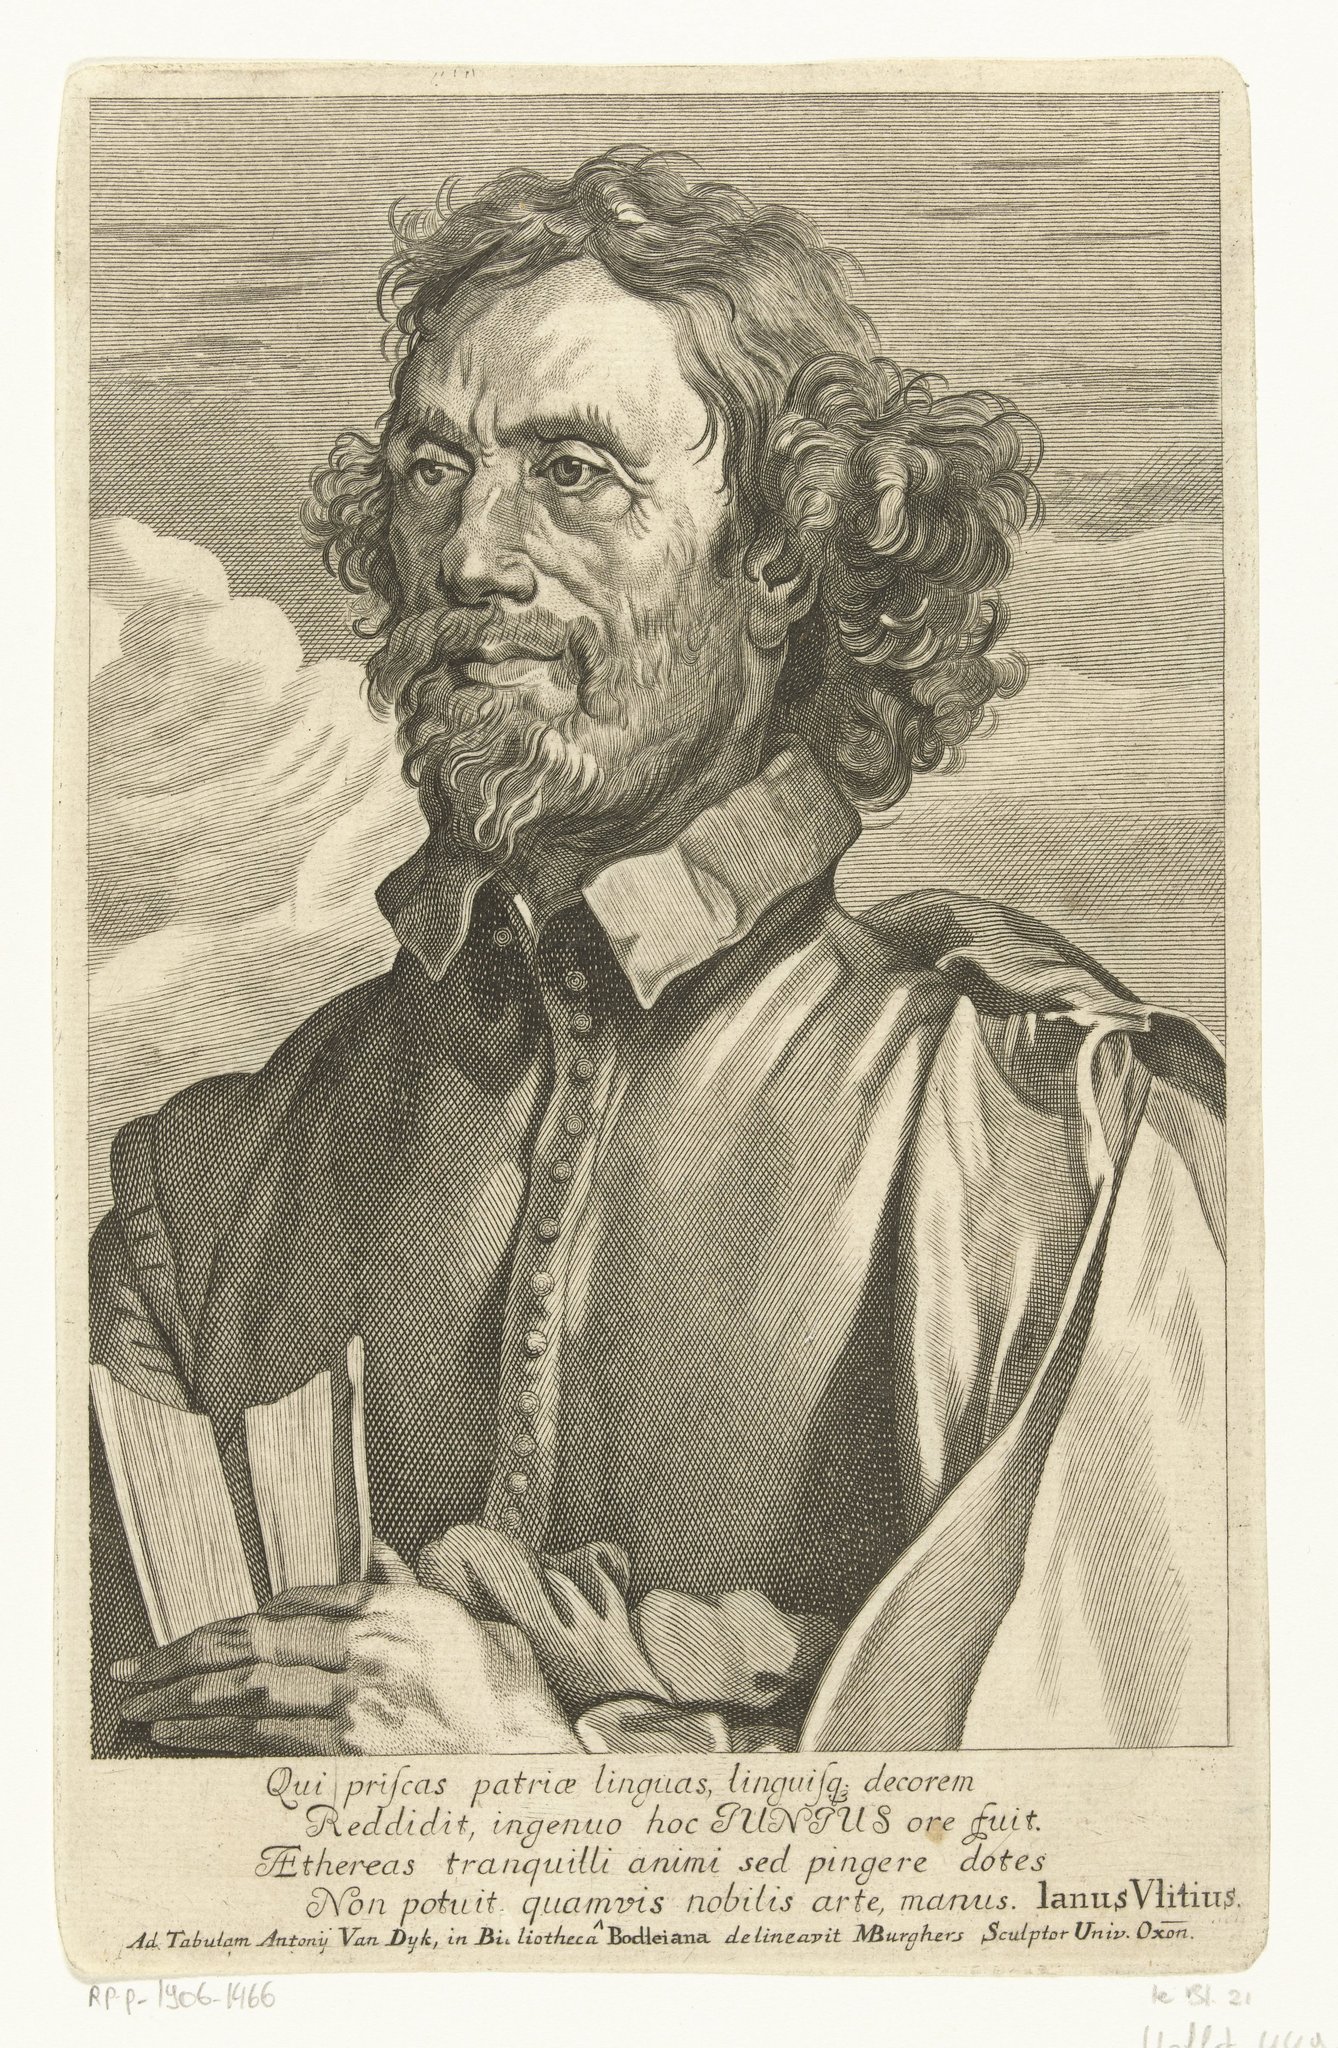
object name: print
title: Portret van François Junius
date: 1698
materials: paper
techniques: engraving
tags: heidelberg, windsor, filoloog, oudheidkundige, franciscus junius (ii)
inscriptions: collector's mark: Lugt 2228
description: Titelpagina uit Koning Alfred, 'An. Manl. Sever. Boethi Consolationis philosophiae libri V : Anglo-Saxonice redditi ab Alfredo, inclyto Anglo-Saxonum rege / ad apographum Junianum expressos edidit Christophorus Rawlinson', Christopher Rawlinson (ed.), Oxford, Sheldonian Theatre press,, 1698.